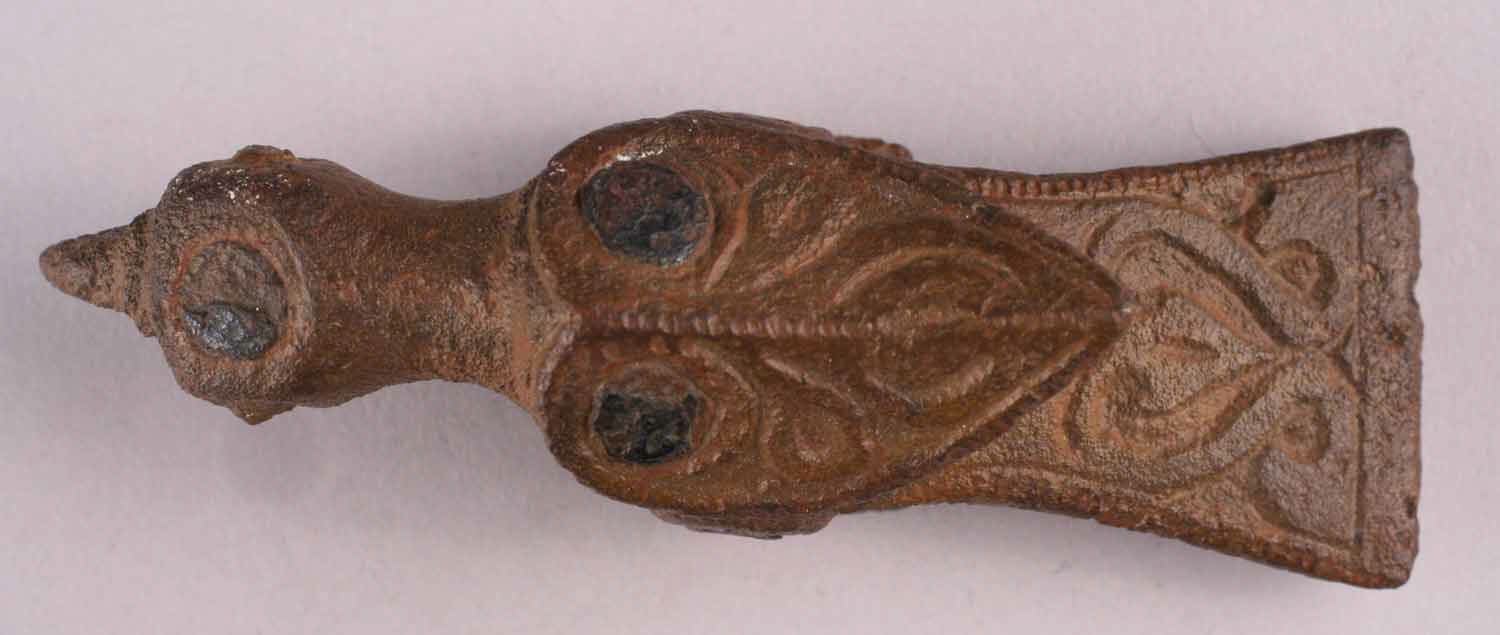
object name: finial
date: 1001-1200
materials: bronze, silver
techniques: casting, incising, inlay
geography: iran